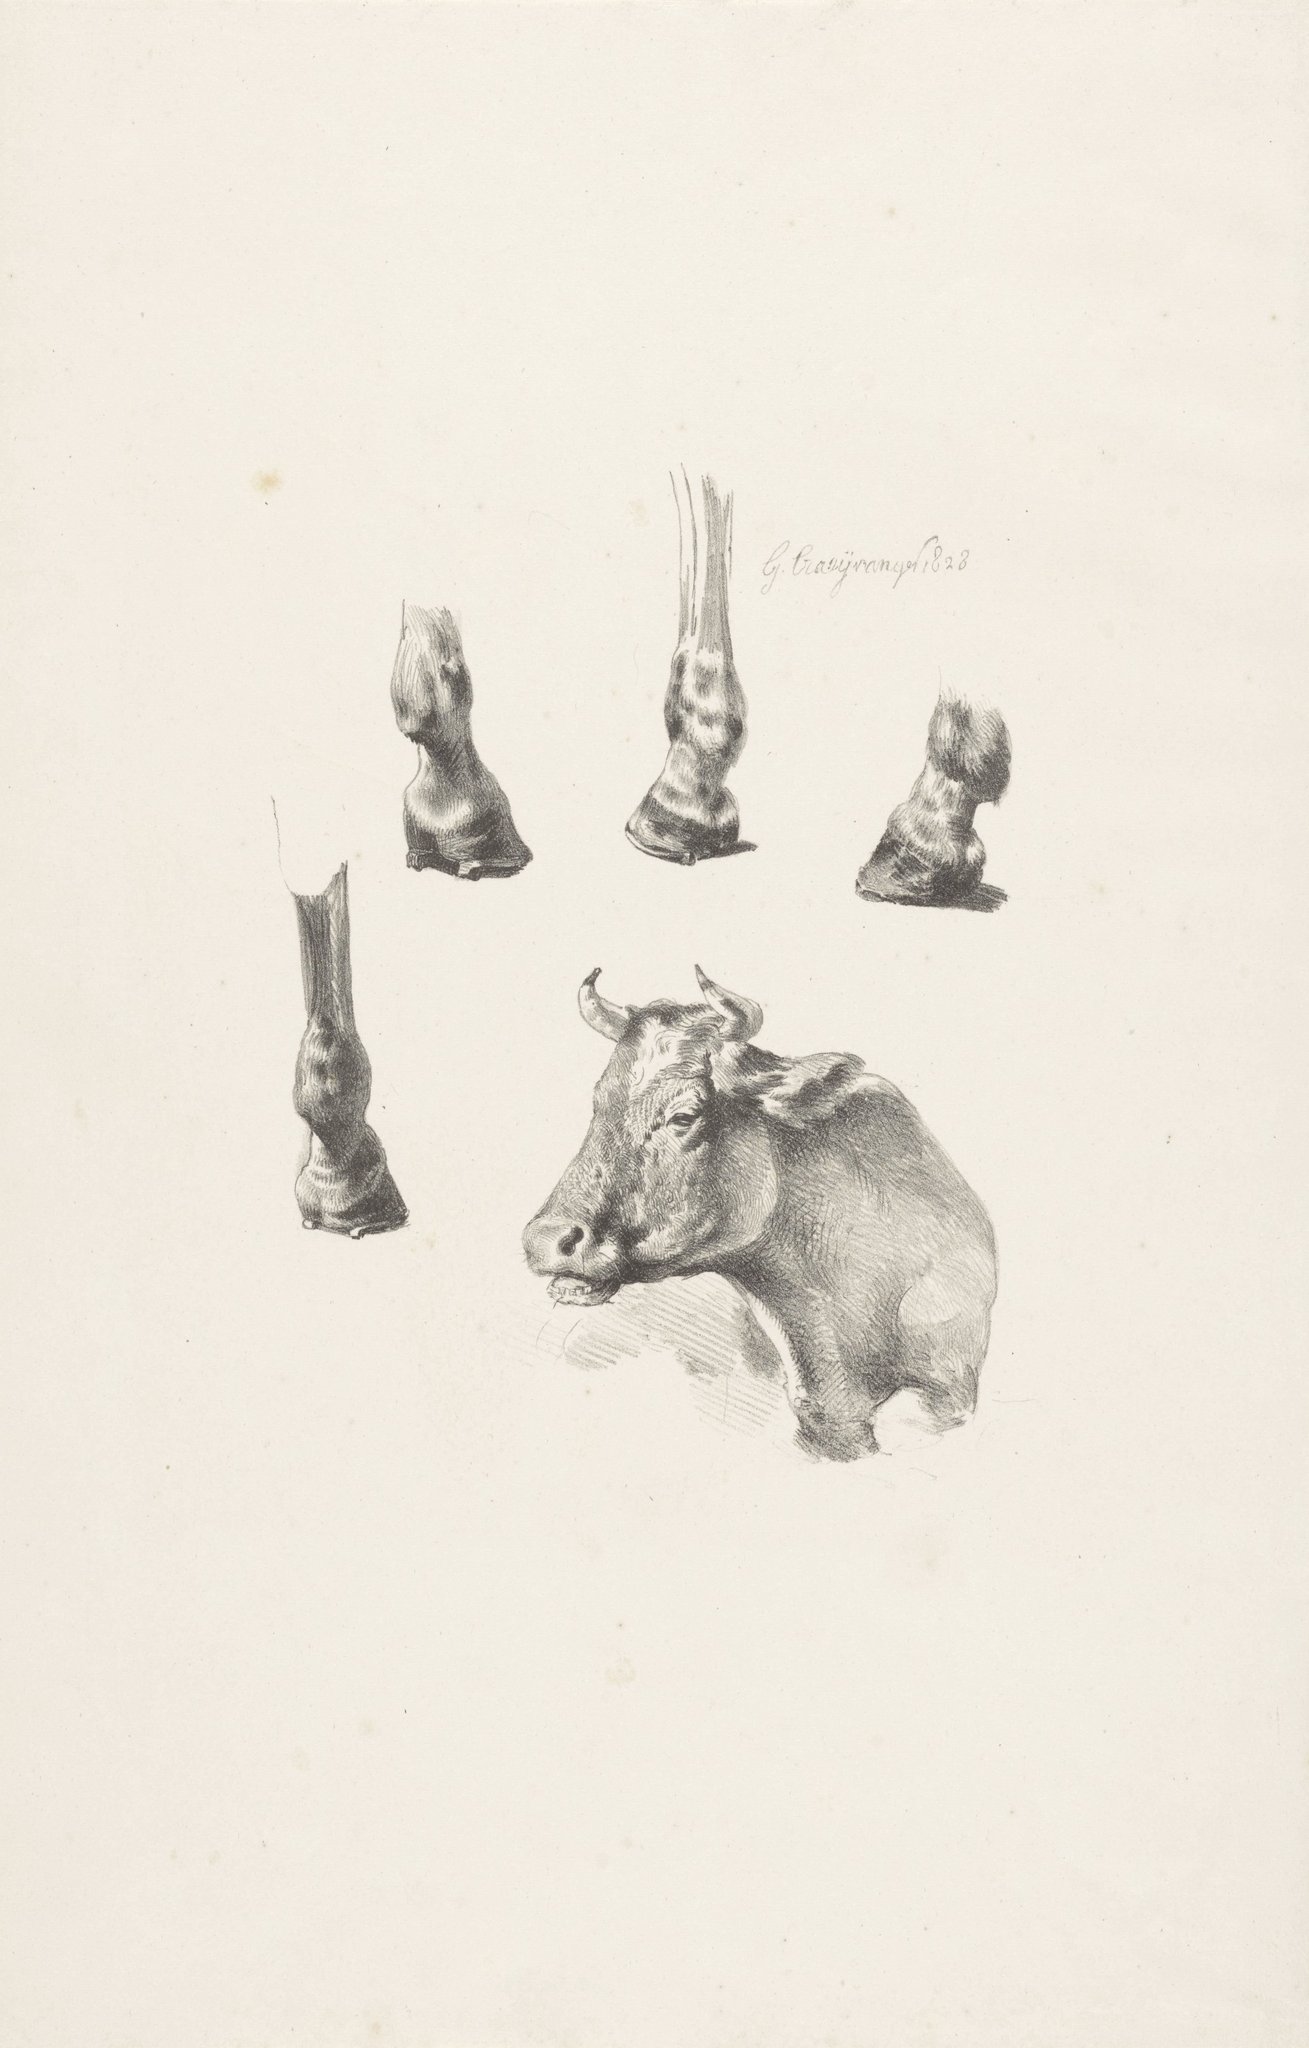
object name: print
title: Een koeienkop en paardenbenen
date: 1828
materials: paper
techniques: lithograph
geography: netherlands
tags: horse (+ limbs of an animal), cow (+ head of an animal)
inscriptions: date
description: Waarschijnlijk is dit een prent voor: 'Beesten Studien naar het Leven op steen gebragt door G. Craeyvanger'. Amsterdam: Francois Buffa & Zoonen, 1828. Zie Swillens in Jaarboek Oud Utrecht. Volgens Swillens gedrukt door Ambroise Jobard. In Lijst van kunstwerken door beoefenaars en verzamelaars bijeengebragt, om verloot te worden ten behoeve van het vaderland; tentoongesteld te Amsterdam, in het nationale geregtshof, Amsterdam (C.A. Spin) 1831, p. 31, nr. 700 vermeld als uitgave van Daiwaille en Veldhuijzen. Daiwaille had eerder samengewerkt met Ambroise Jobard.